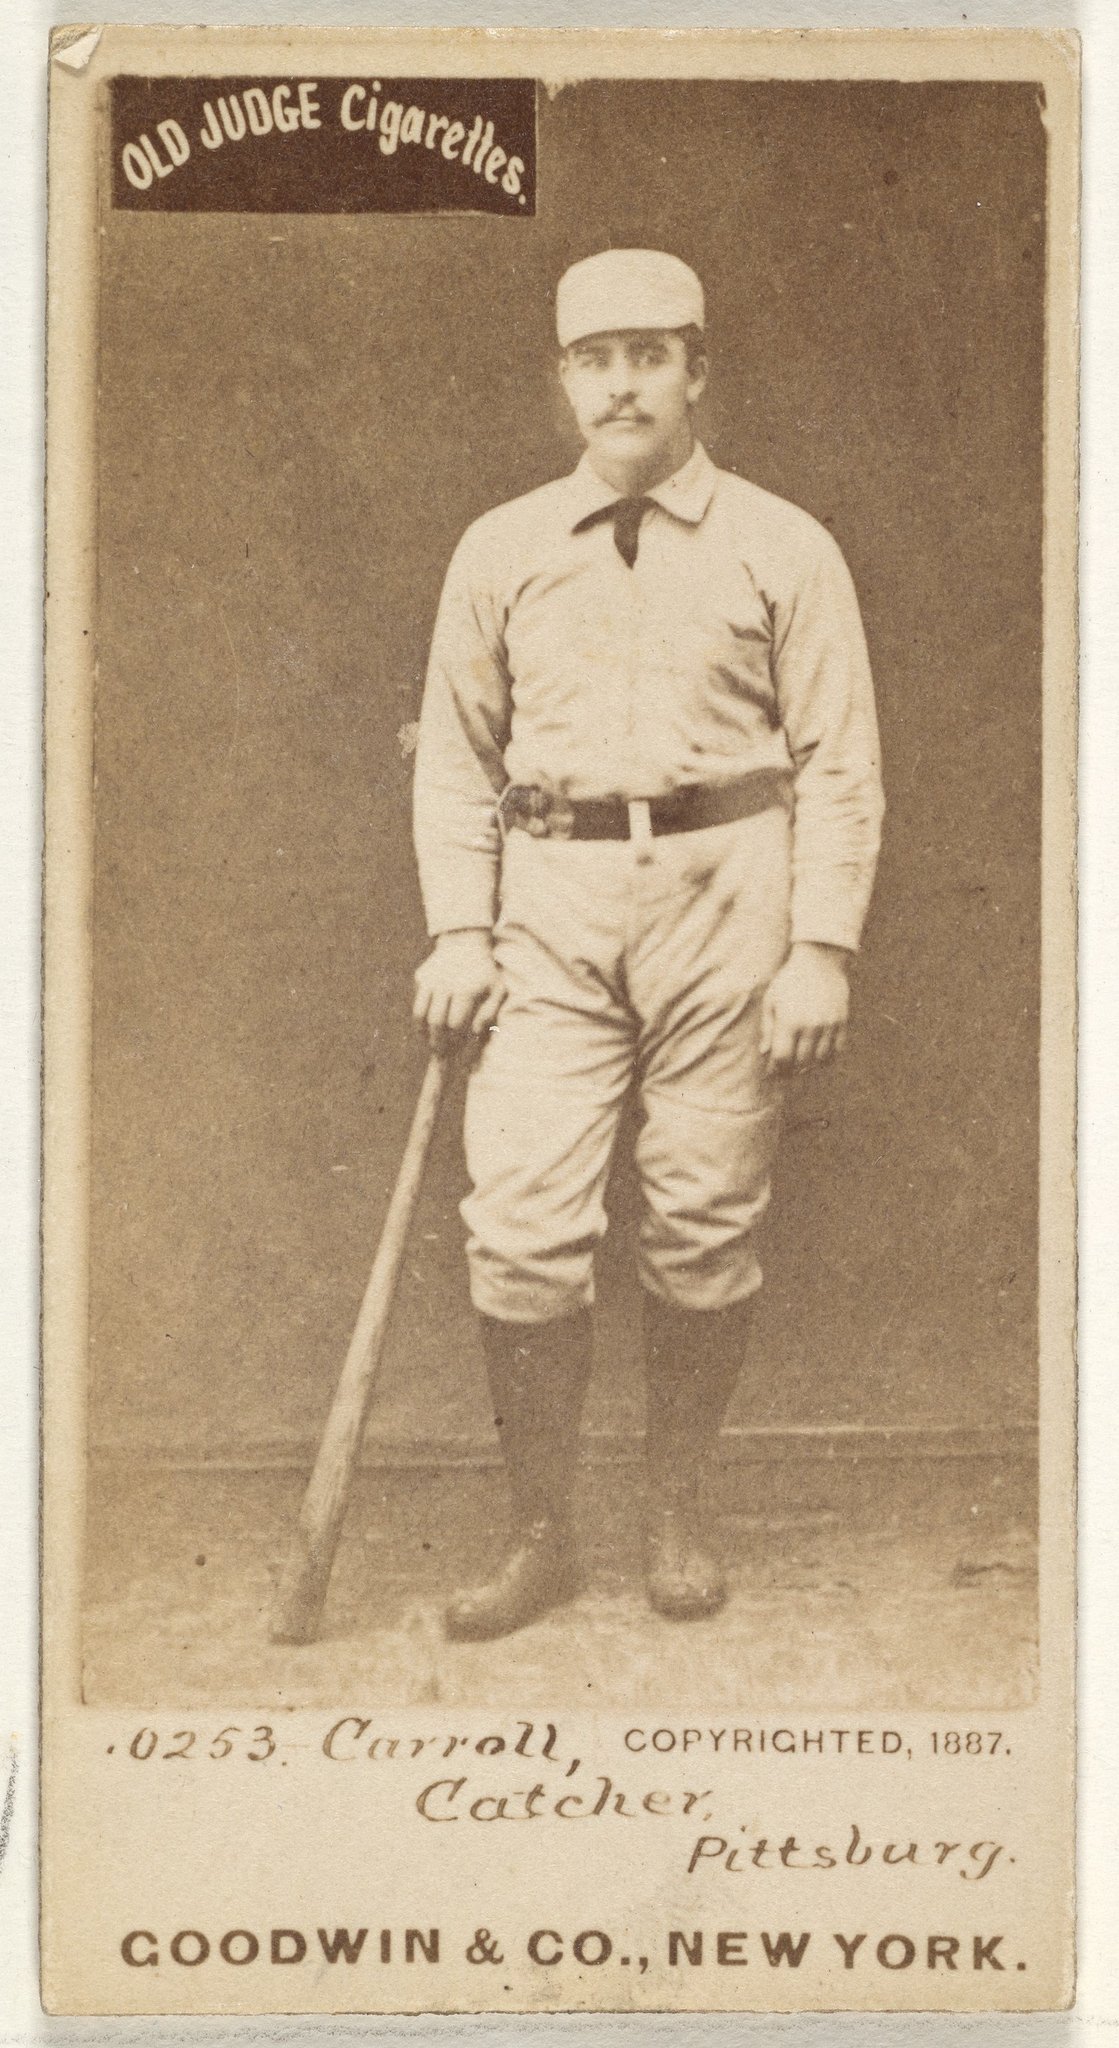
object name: baseball card, photograph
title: Frederick Herbert "Fred" Carroll, Catcher, Pittsburgh, from the Old Judge series (N172) for Old Judge Cigarettes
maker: goodwin & company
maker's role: publisher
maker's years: 1850-1950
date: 1887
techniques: albumen silver print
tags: men,portraits,baseball,athletes